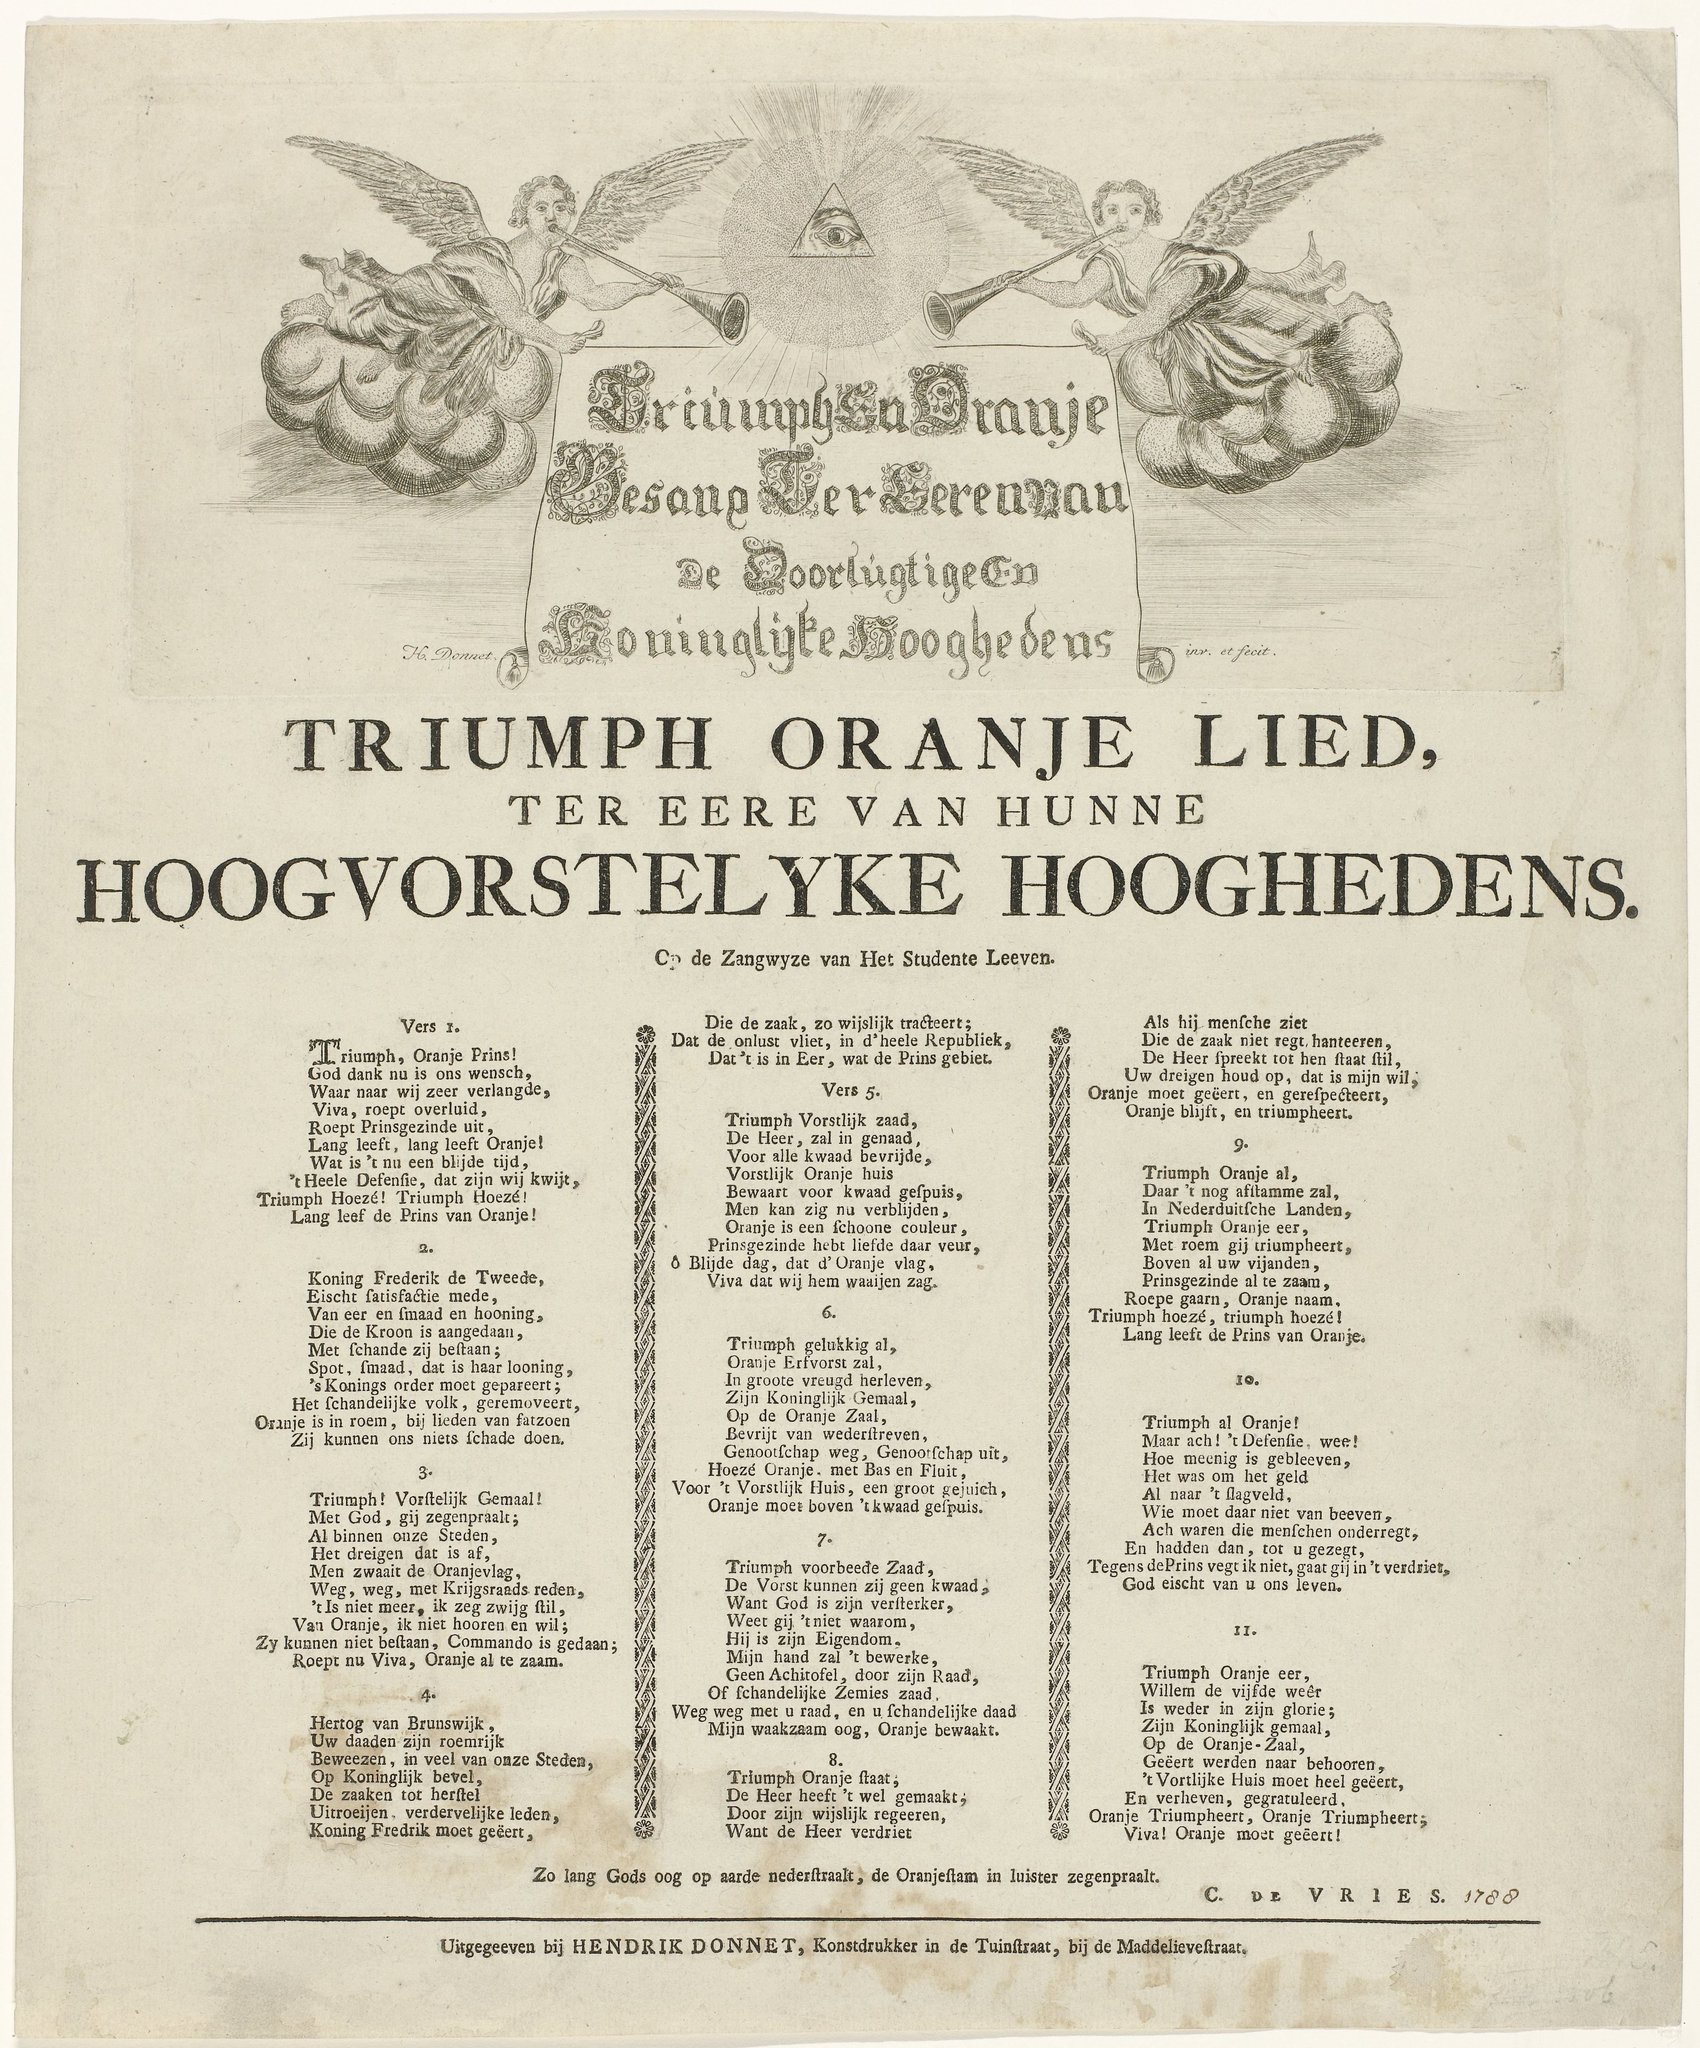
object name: song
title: Triumph en Oranje Gesang ter Eeren van de Doorlugtige en Koninglijke Hooghedens / Triumph Oranje Lied, ter eere van hunne Hoogvorstelyke Hooghedens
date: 1787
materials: paper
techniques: engraving, letterpress printing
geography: amsterdam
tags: the hague, william v (prince of orange)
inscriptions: collector's mark: Lugt 2228, inscription: ‘1788’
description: Lied op het herstel van prins Willem V in 1787. Bovenaan twee engelen met bazuinen die een banderol met de titel vasthouden, daarboven het Alziende Oog. Op het blad onder de plaat zijn de elf coupletten van het lied gedrukt.